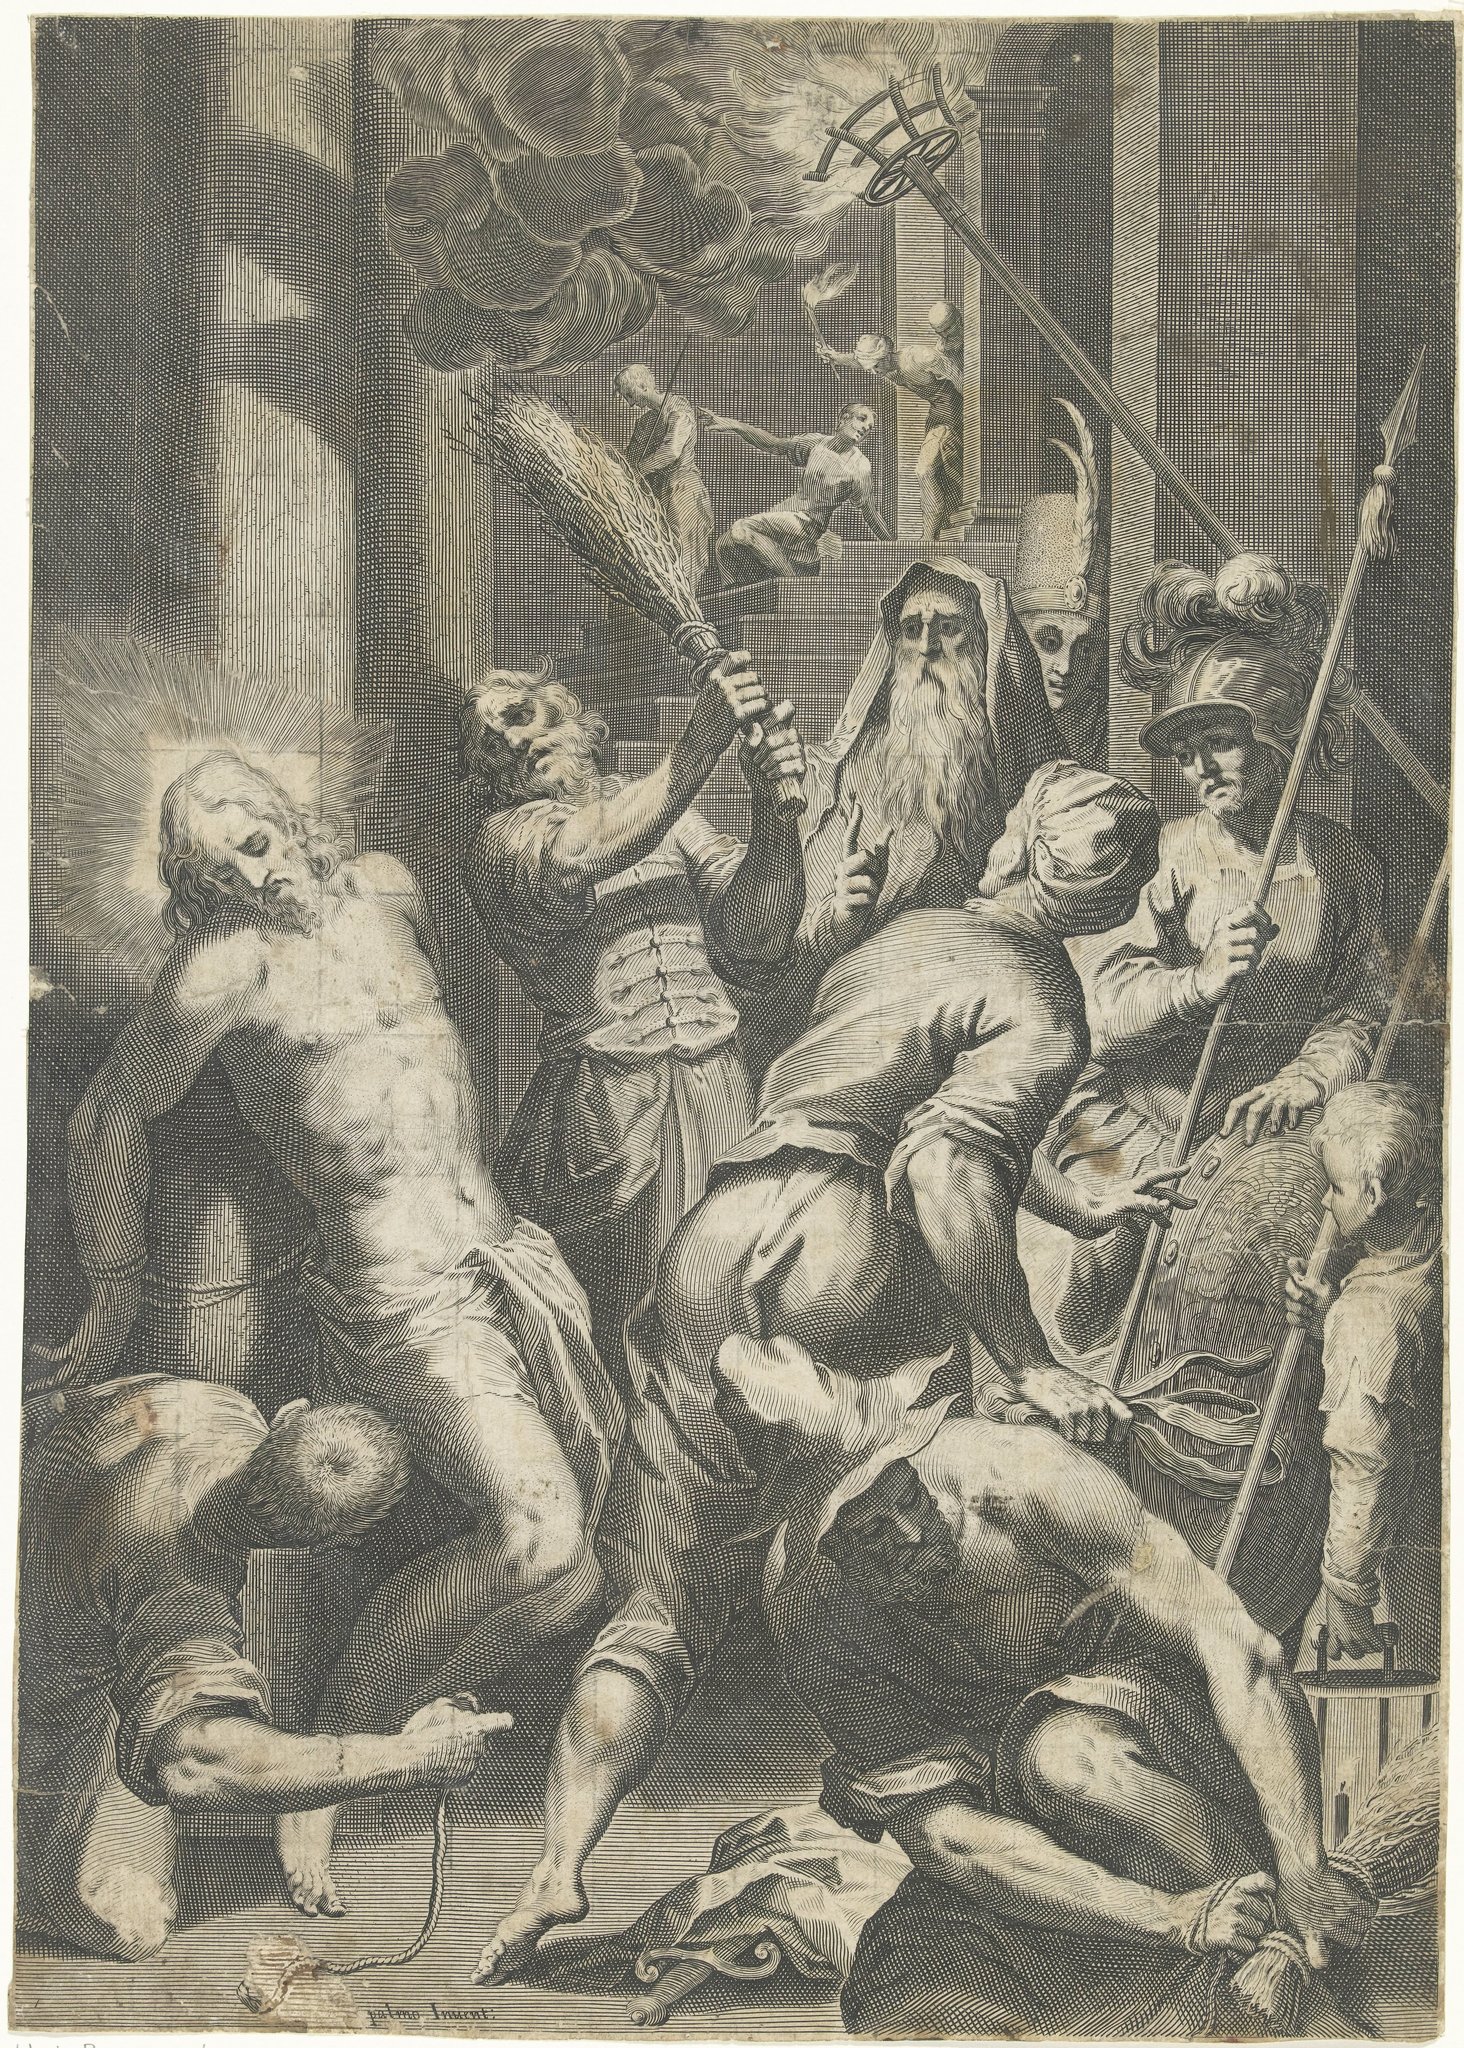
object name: print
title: Geseling van Christus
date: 1594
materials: paper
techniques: engraving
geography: munich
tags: flagellation by soldiers, christ usually tied to a column (matthew 27:26; mark 15:15; john 19:1)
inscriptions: collector's mark: Lugt 10, collector's mark: Lugt 11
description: Christus, vastgebonden aan een pilaar, wordt door soldaten gegeseld.